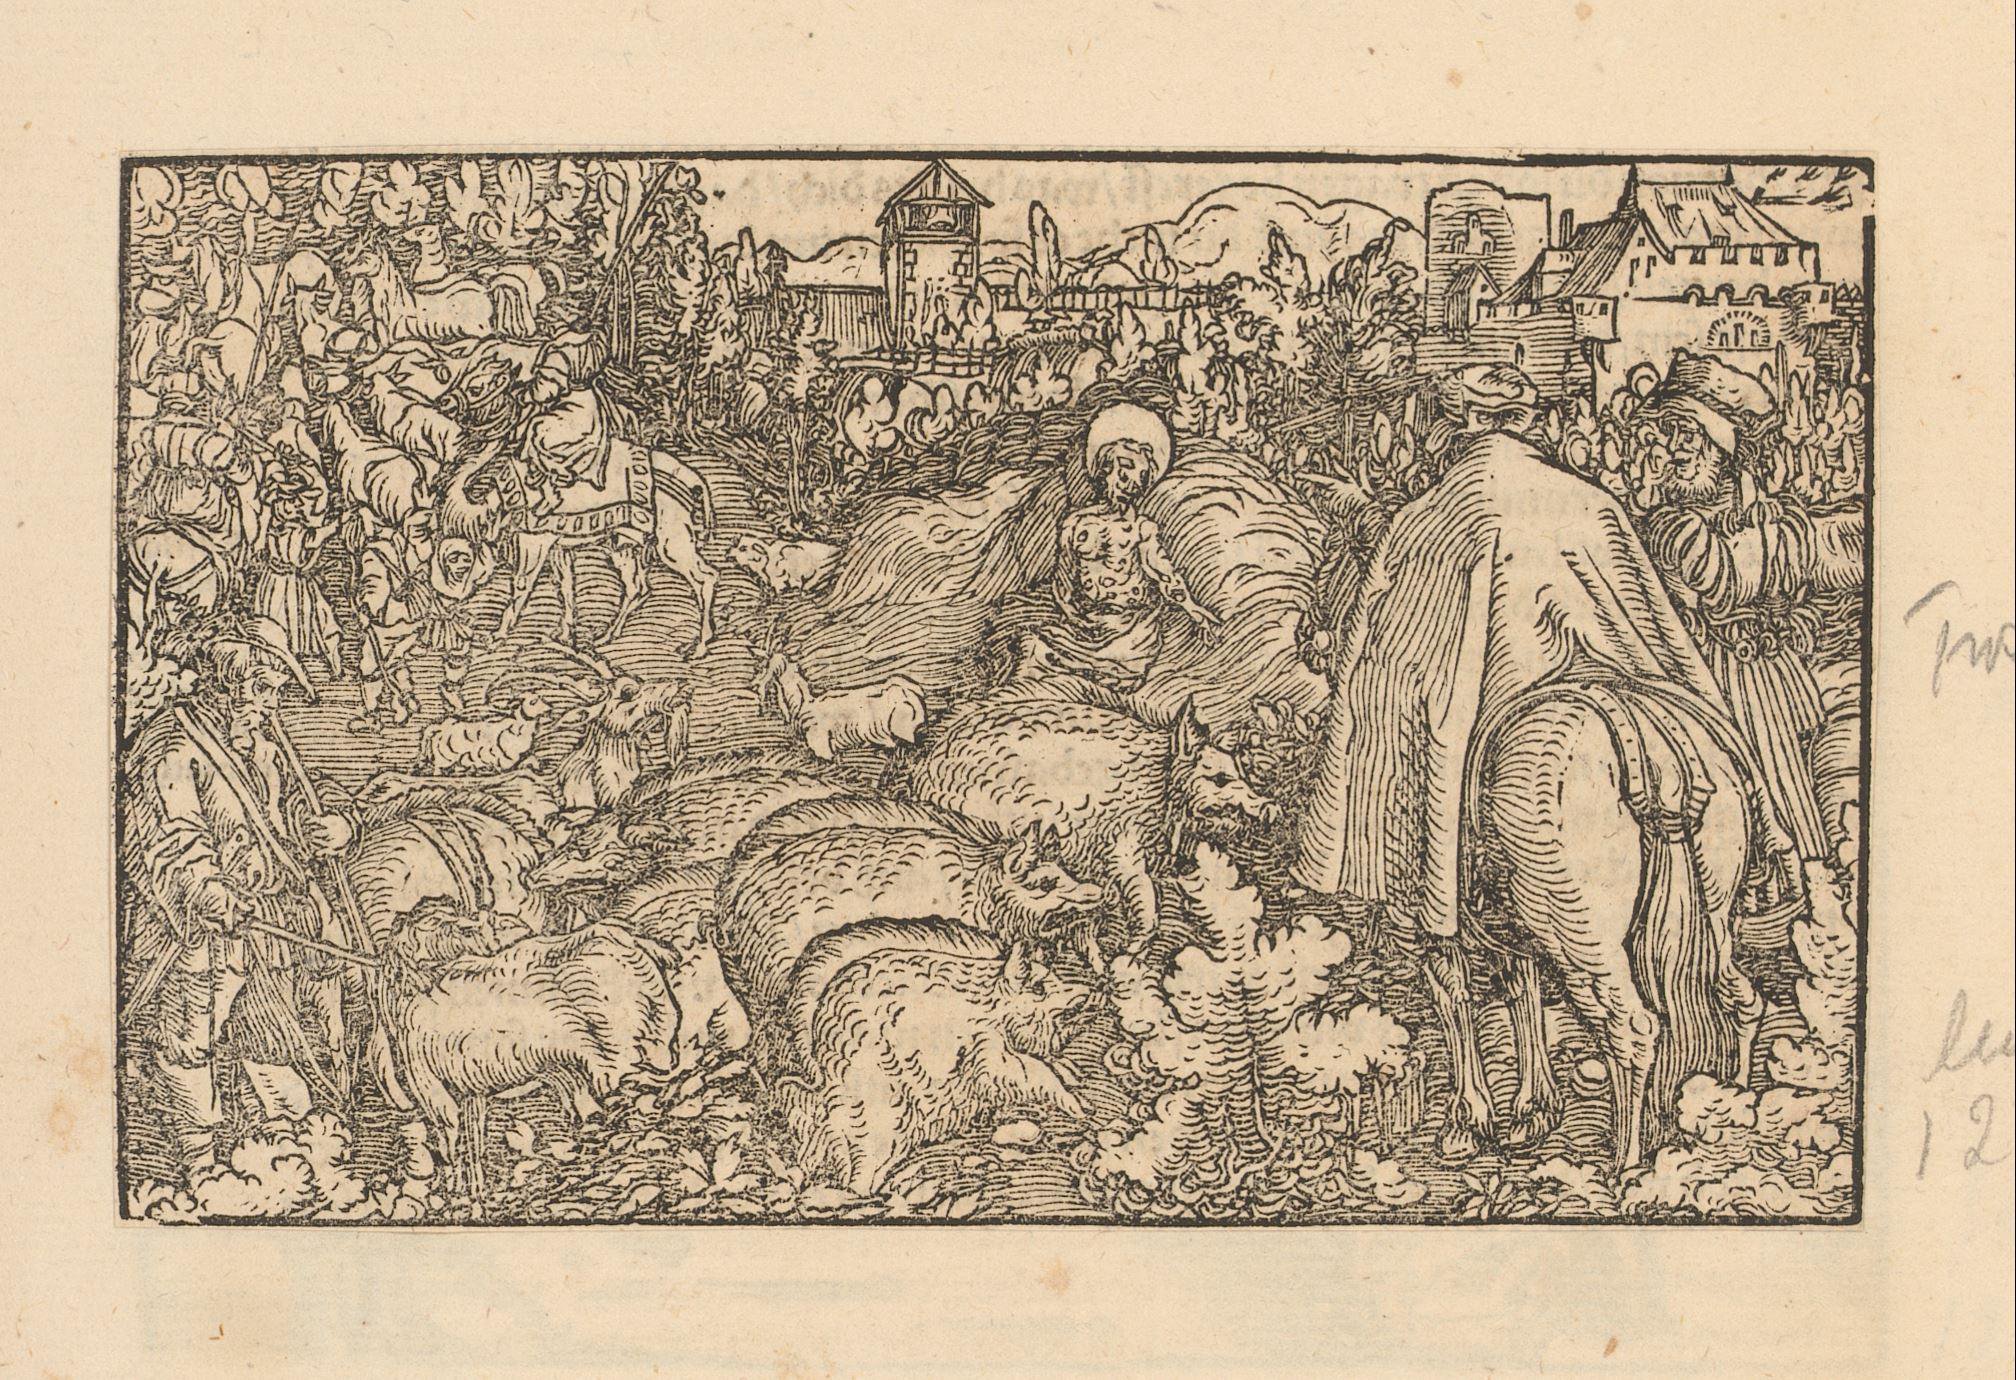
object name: album leaf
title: Herders drijven vee en op de achtergrond Job op een mesthoop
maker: Anonymous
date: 1514-1532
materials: paper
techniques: letterpress printing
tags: animals (+ excrement, dung of animal(s)), job covered with sores (or boils) takes his abode on a dunghill (pile of ashes) and scrapes his body with a potsherd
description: Deze prent is gebruikt in: Petrarca, Francesco. Von der Artzney bayder Glück, des guten und widerwertigen: unnd weß sich ain yeder inn Gelück und Unglück halten sol (...). Augsburg: Heinrich Steiner, 1532. Deze uitgave is ook bekend onder de titel 'Trostspiegel in Glück und Unglück'.